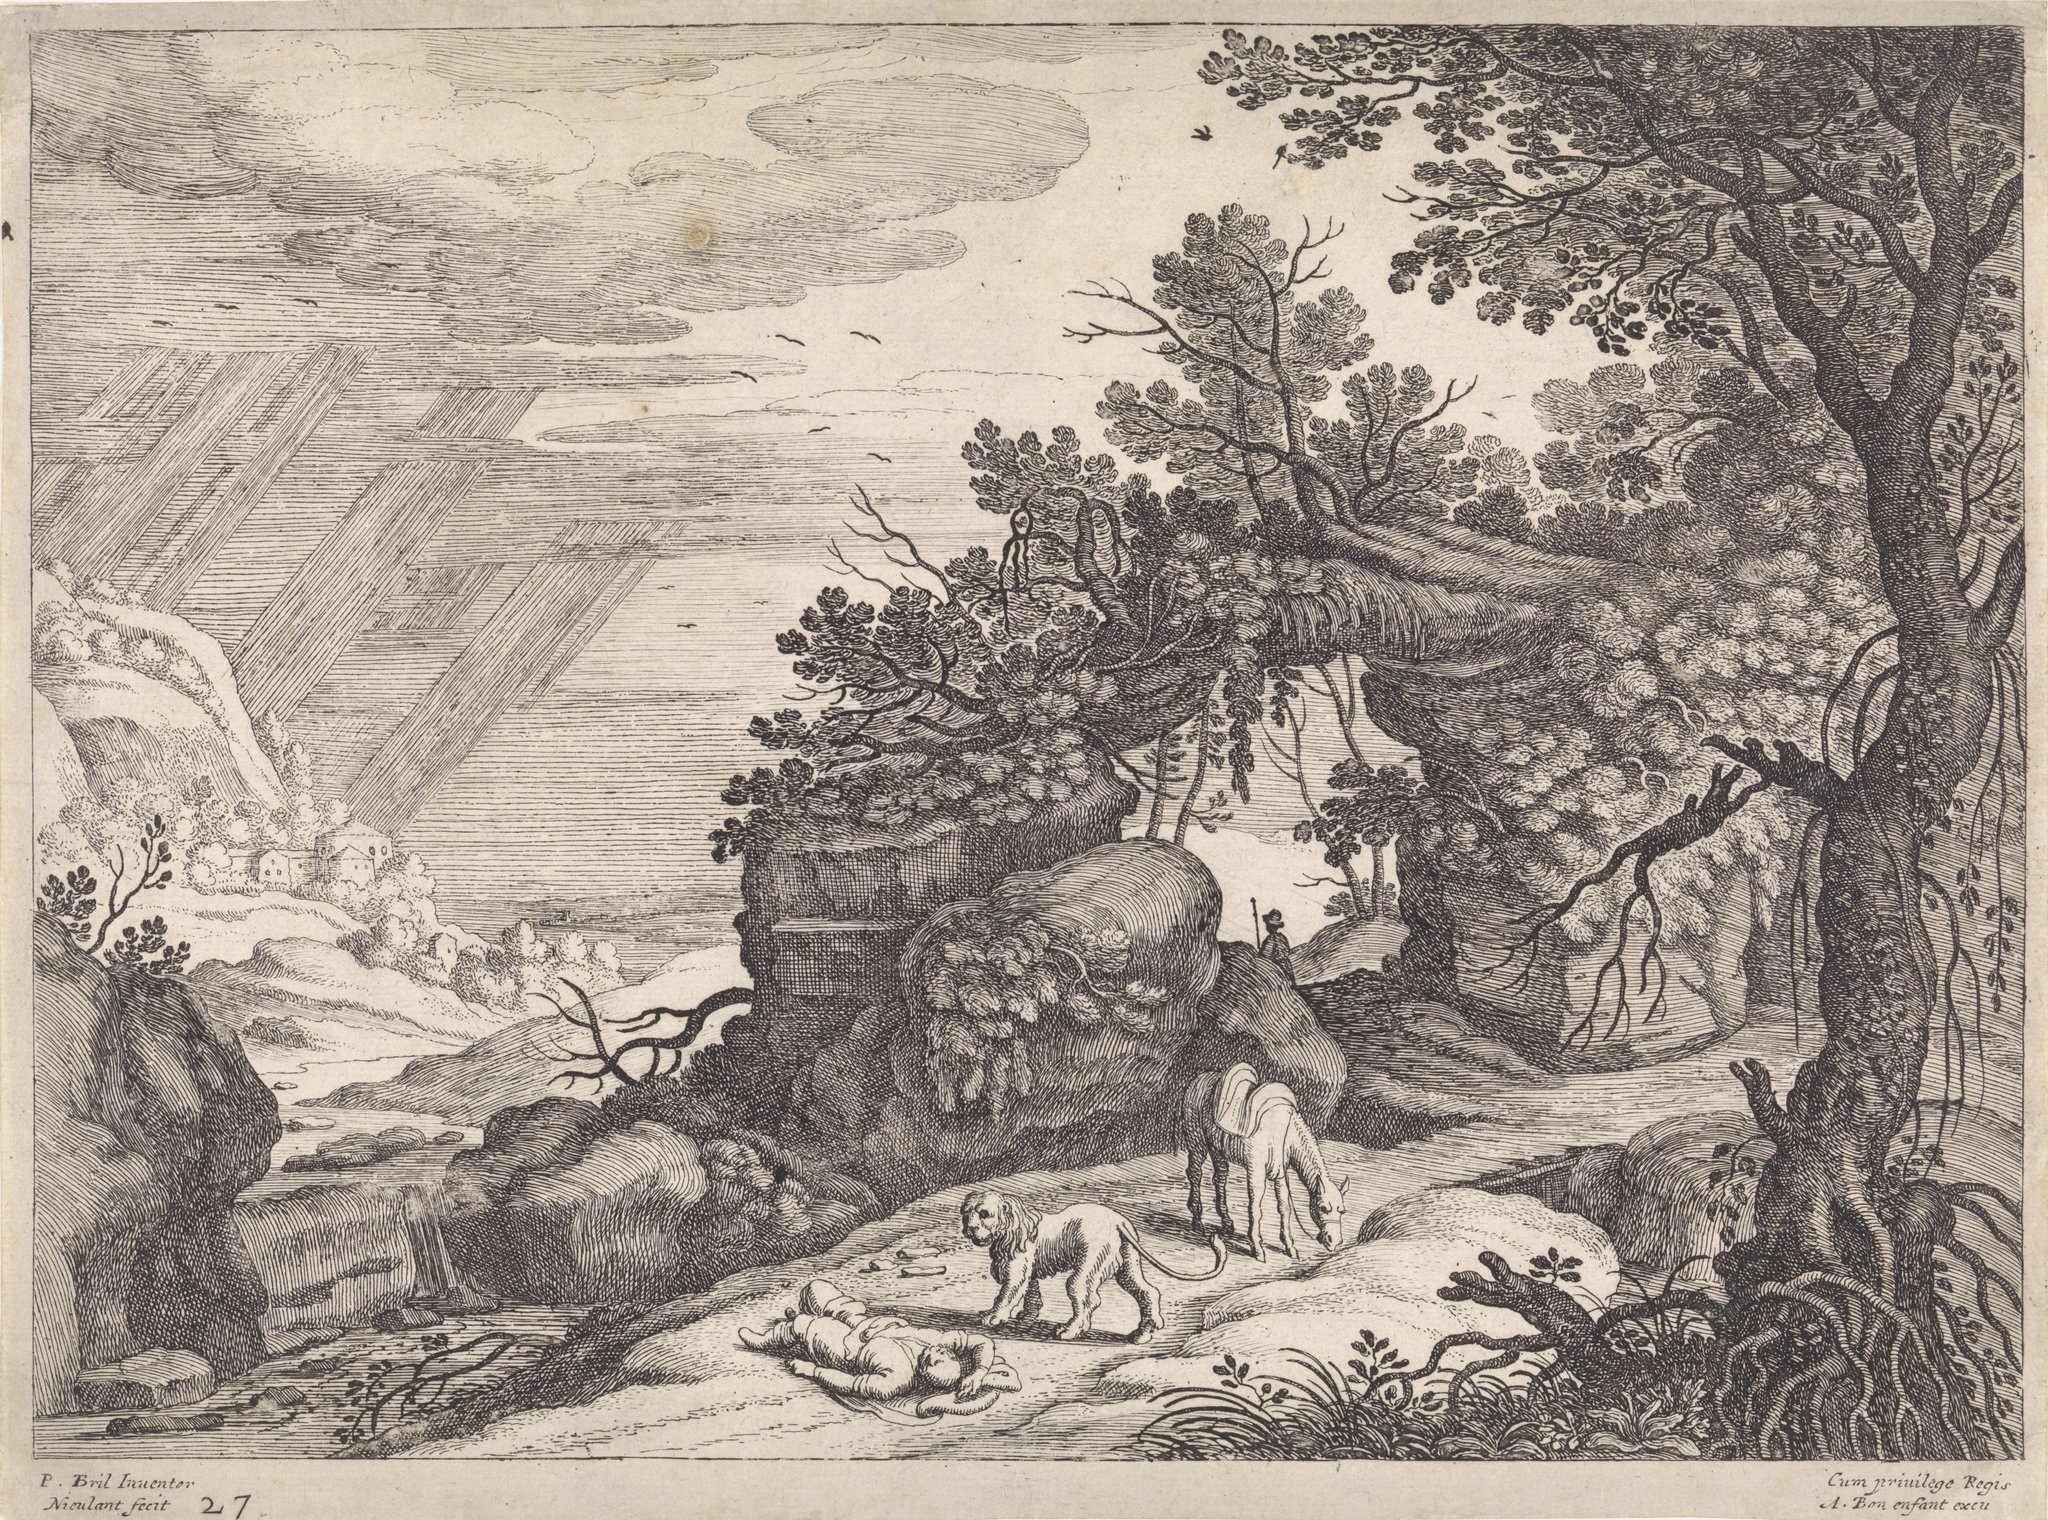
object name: print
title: Italiaanse landschappen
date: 1594-1635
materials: paper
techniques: engraving, etching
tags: the body of the prophet of judah lies intact on the road with the donkey and the lion beside it, landscapes in the temperate zone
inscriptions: collector's mark: Lugt 2228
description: De gestorven godsman uit Juda op de weg. Naast hem staan de leeuw en de ezel. De godsman was tegen de opdracht van God in gegaan door toch in Betel te eten en te drinken. Toen hij daar vandaan ging werd hij door een leeuw aangevallen en gedood, maar niet verslonden. Naar het Bijbelverhaal uit 1 Kon. 13: 23-28. Prent uit een serie Italiaanse landschappen.